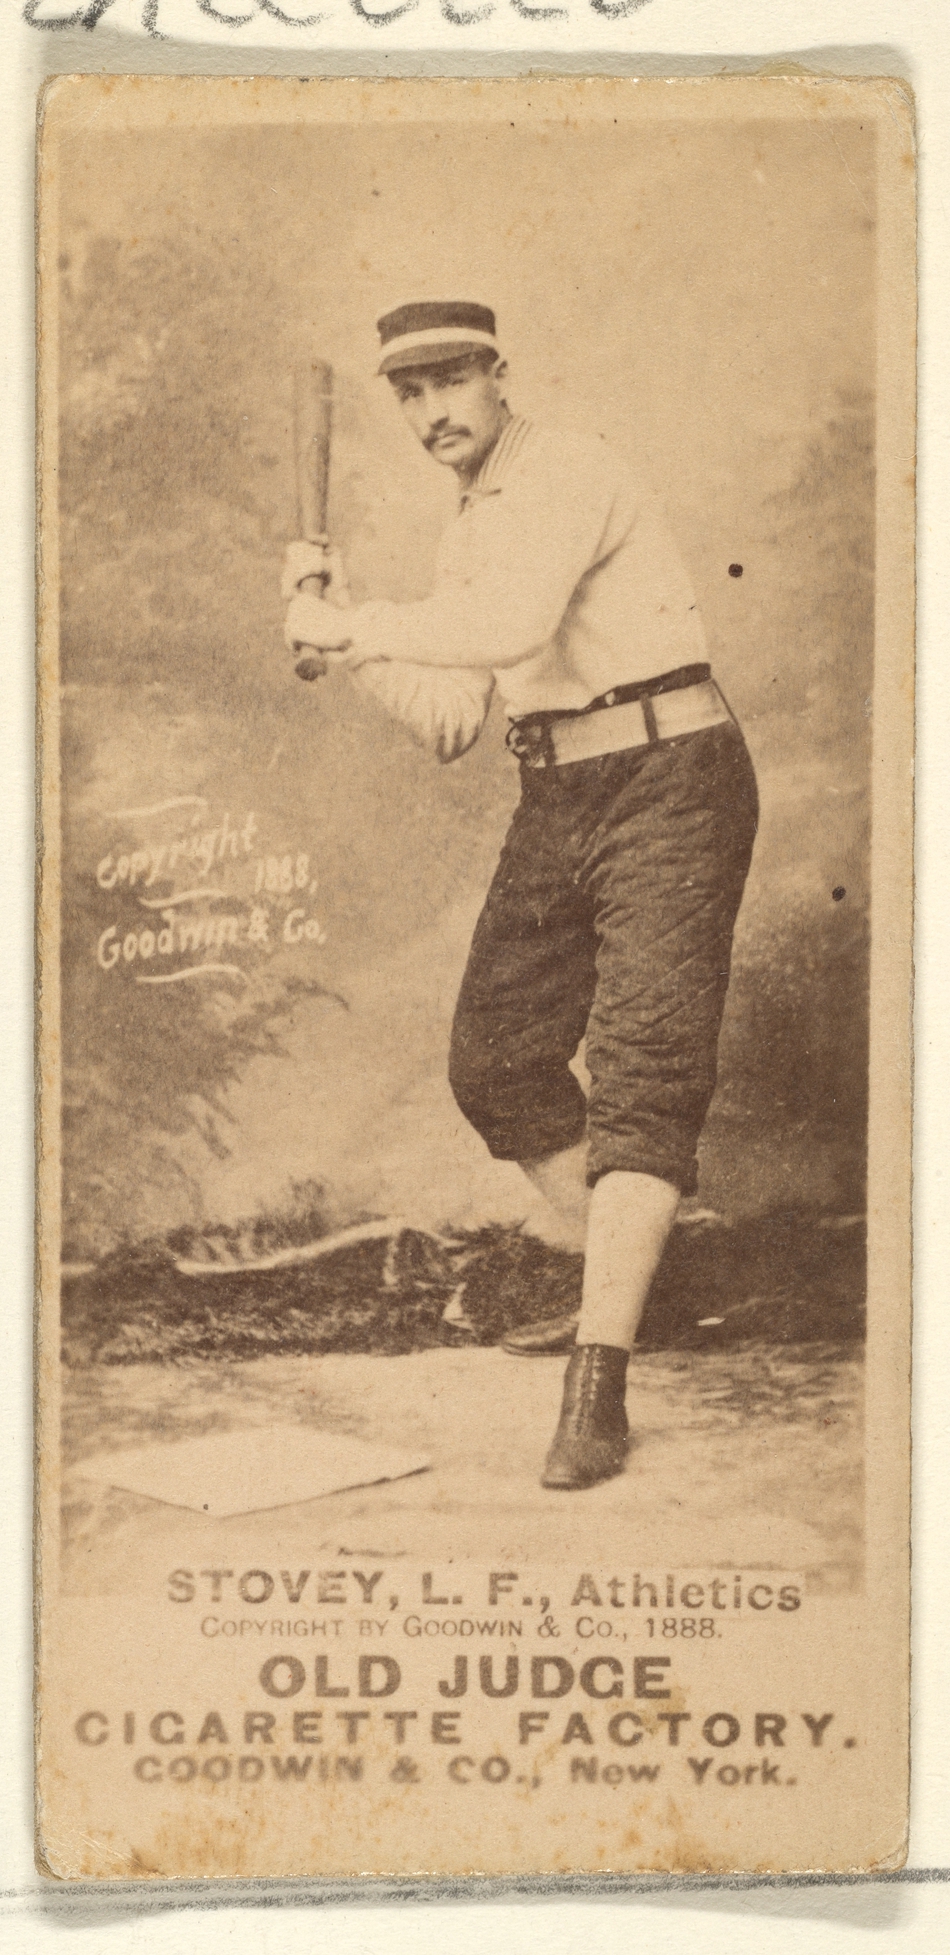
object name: baseball card, photograph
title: Stovey, Left Field, Philadelphia Athletics, from the Old Judge series (N172) for Old Judge Cigarettes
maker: goodwin & company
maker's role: publisher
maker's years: 1850-1950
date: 1888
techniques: albumen silver print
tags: men,portraits,baseball,athletes